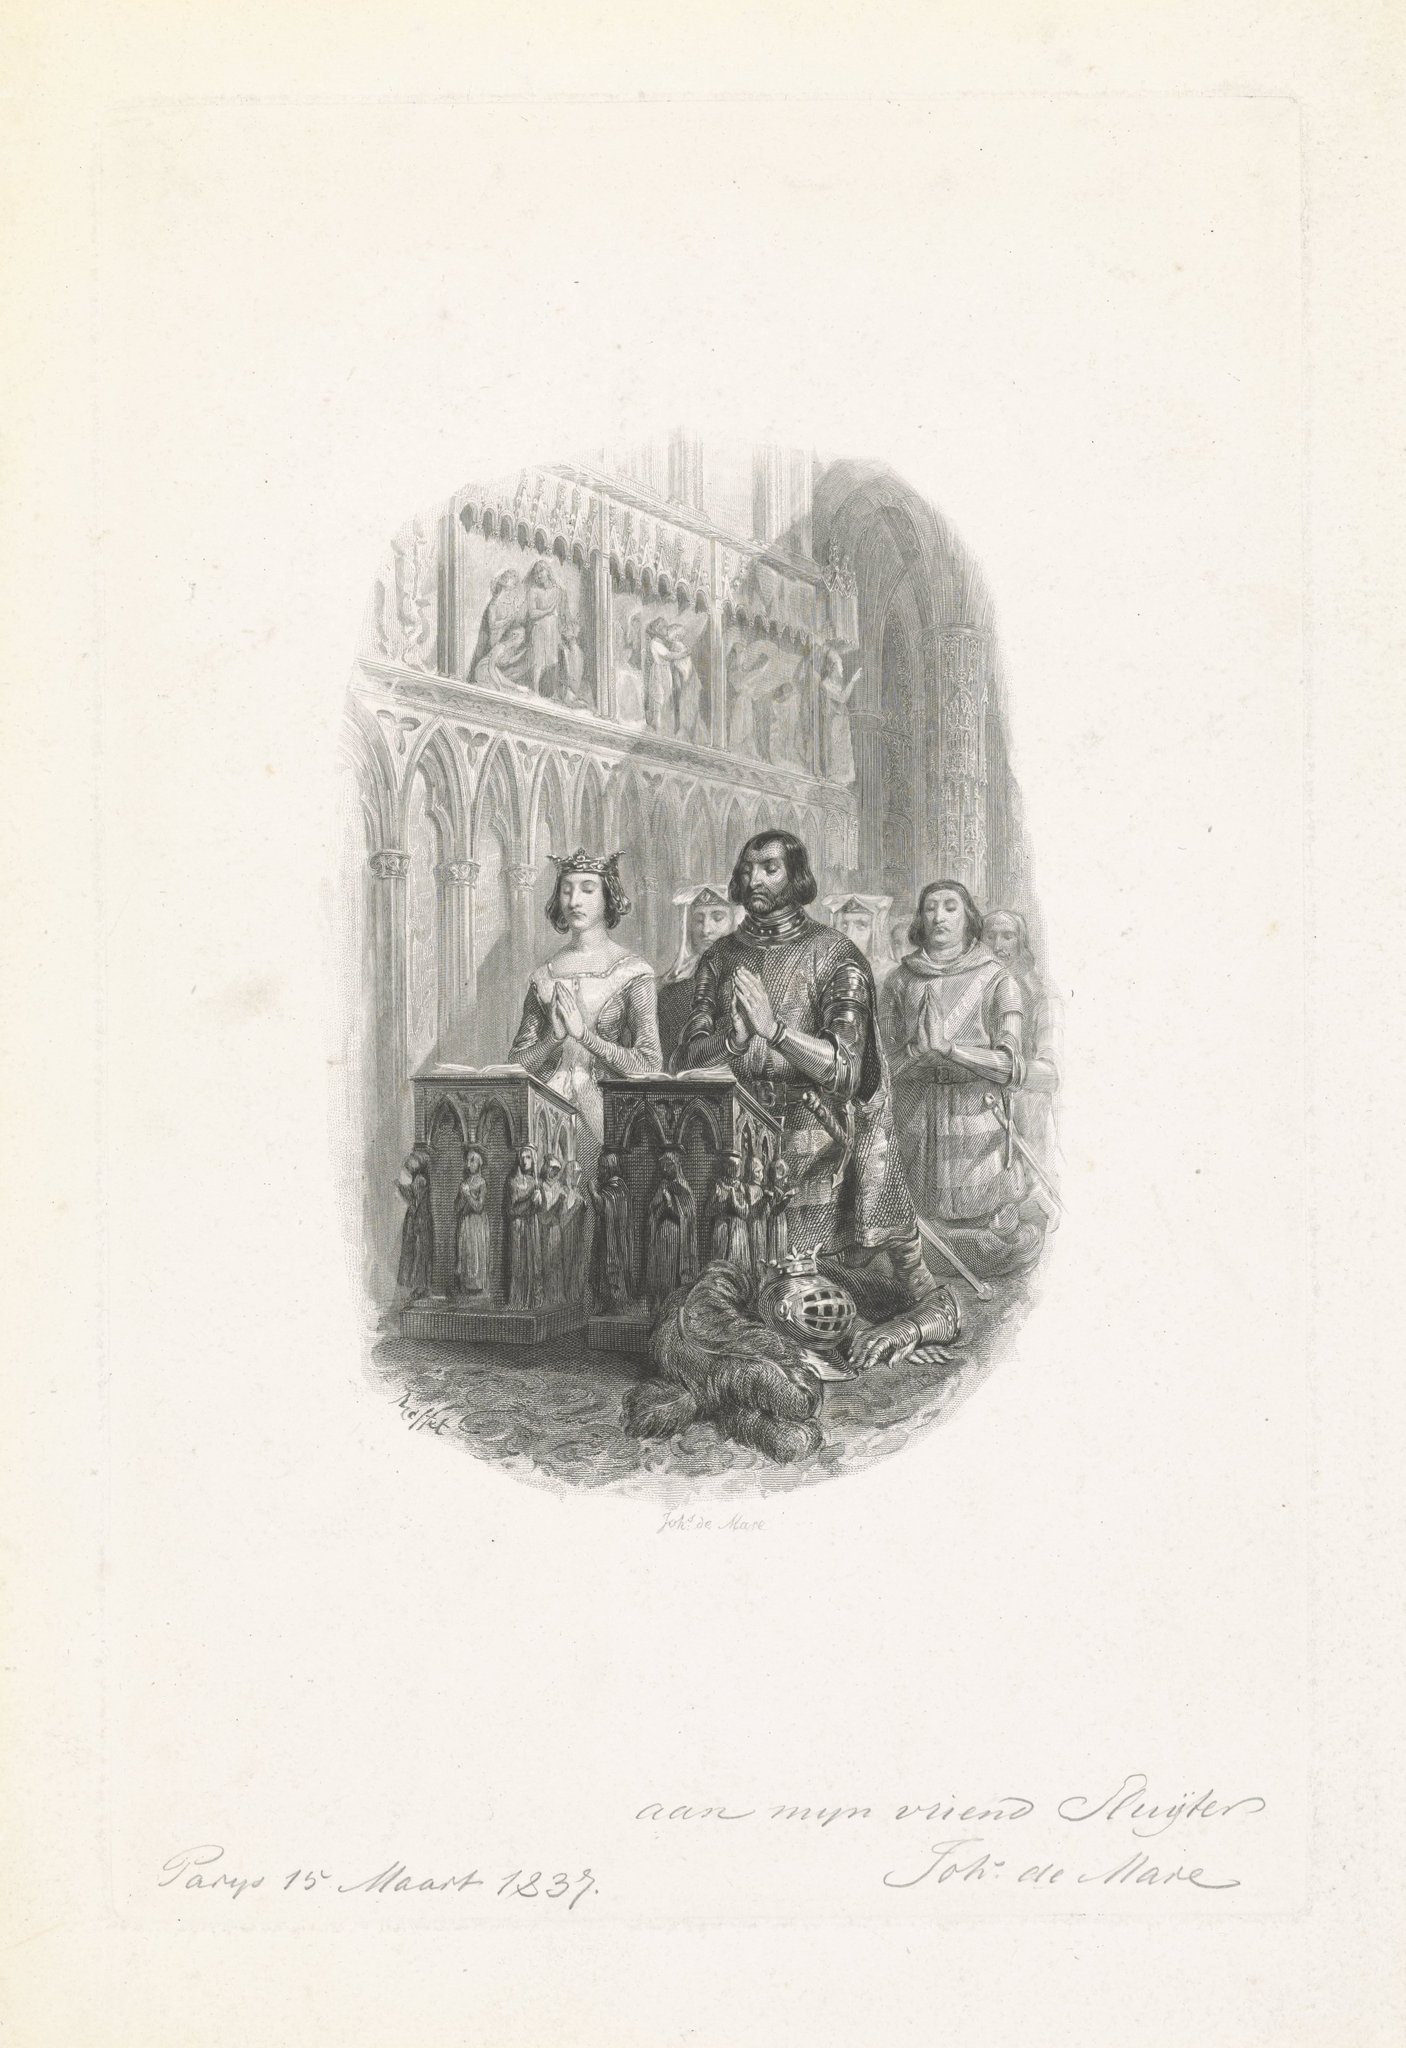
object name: print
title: Ridder en dame tijdens kerkdienst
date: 1816-1837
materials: paper, pencil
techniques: engraving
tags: helmet, armour, holy mass (divine service, especially of roman catholic church)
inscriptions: collector's mark: Lugt 2228, dedication: ‘aan mijn vriend Sluijter/ Joh. de Mare’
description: Een geknielde ridder tijdens een kerkdienst met naast hem op de grond zijn helm en handschoenen. Links van hem een dame.